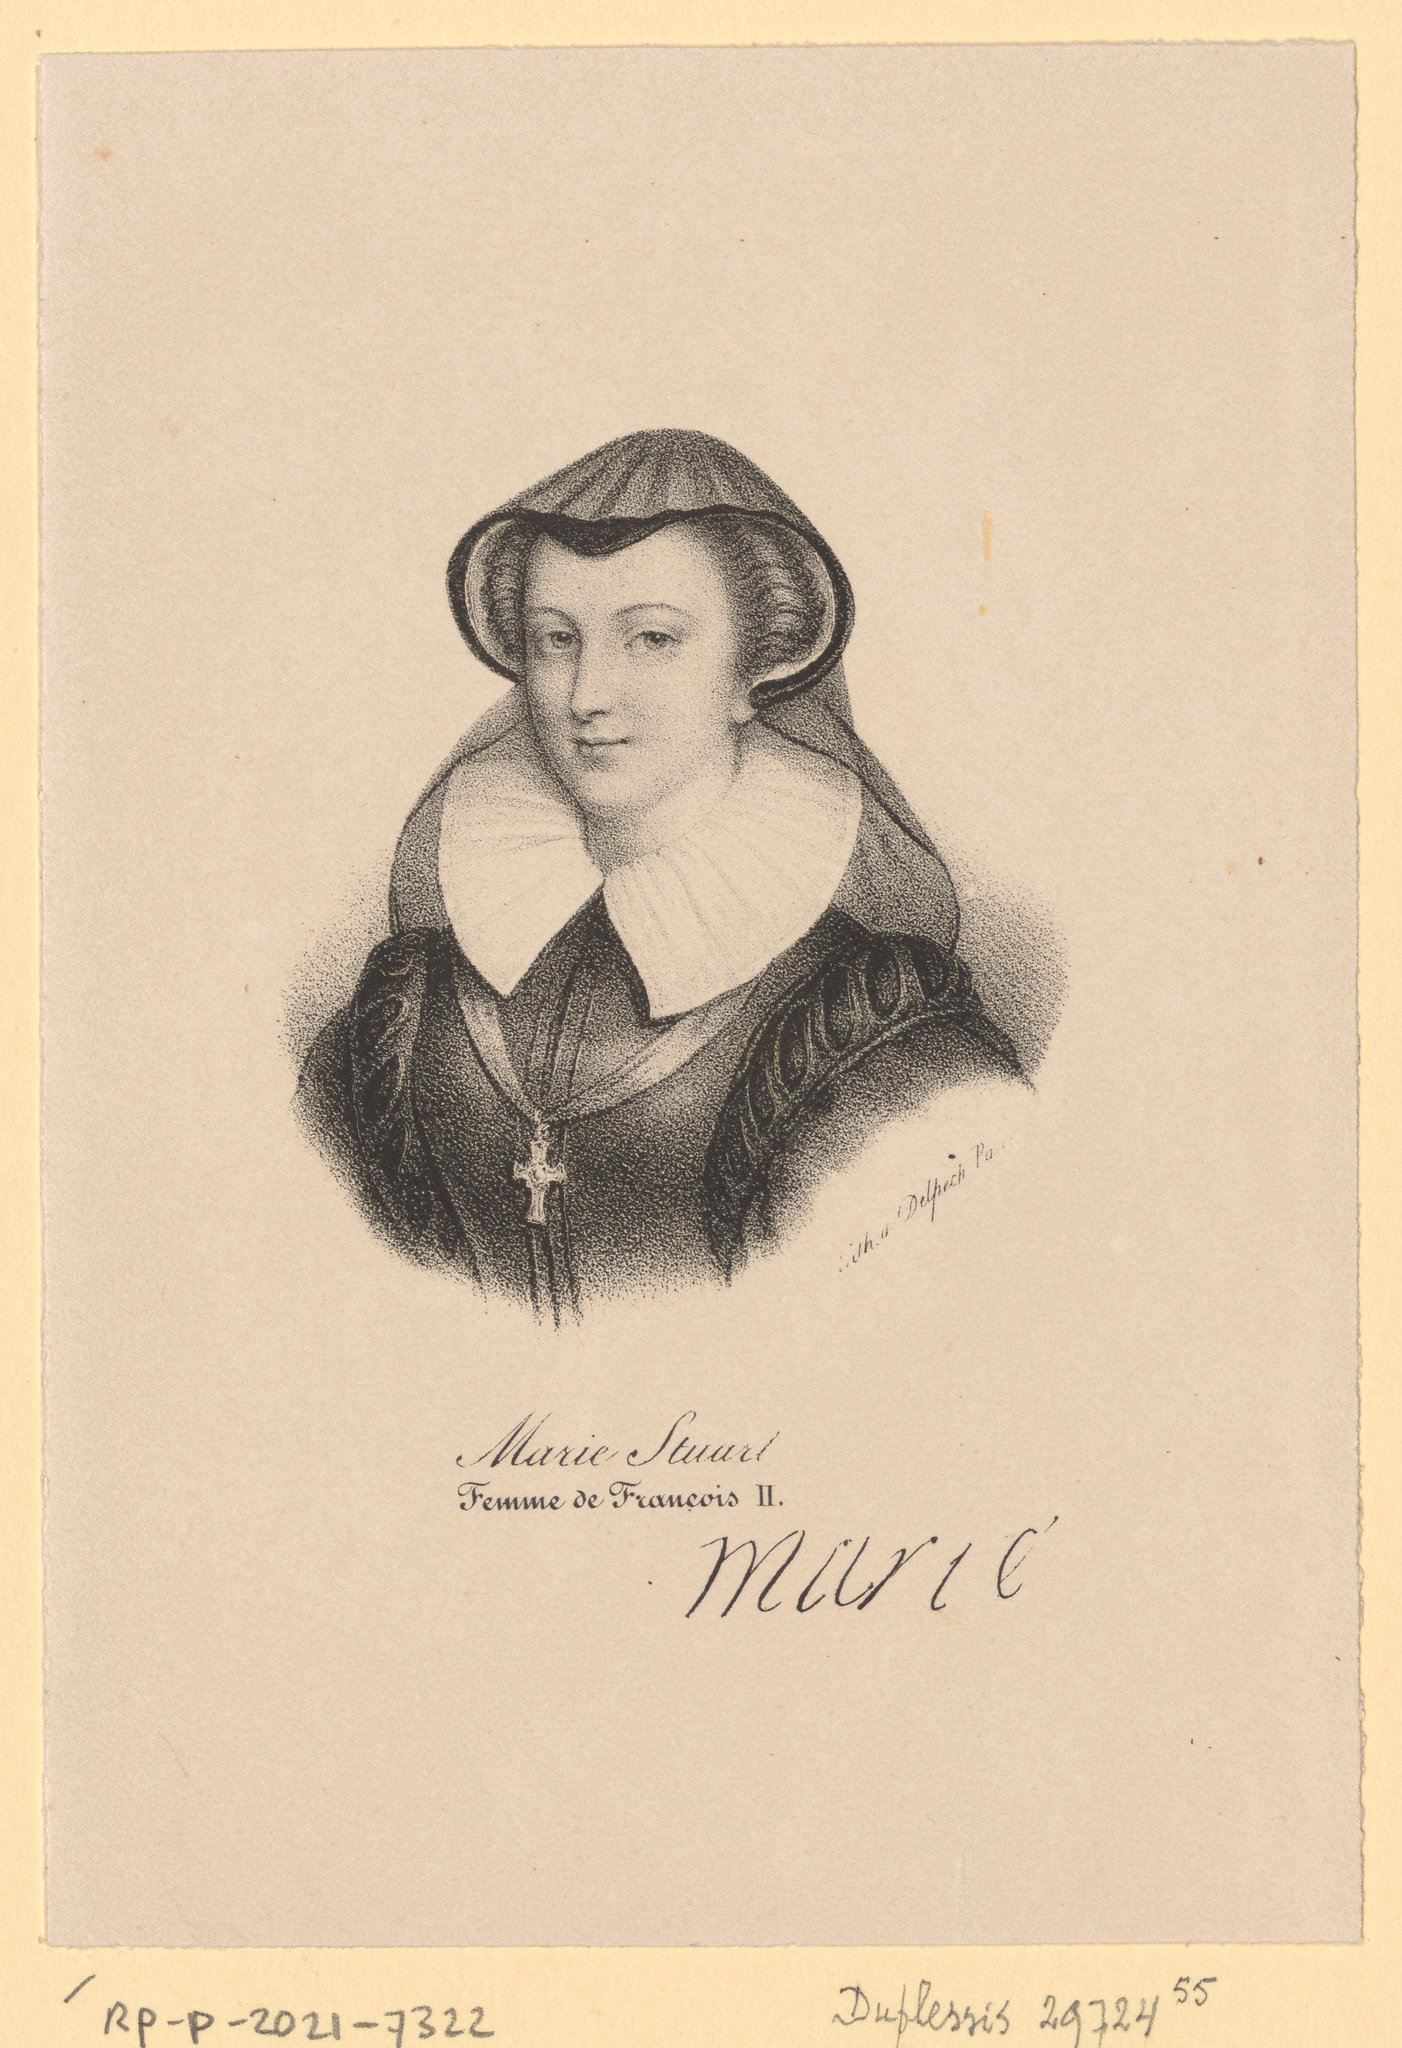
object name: print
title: Portret van Maria I van Schotland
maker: Anonymous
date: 1818-1842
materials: paper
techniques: lithograph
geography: france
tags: historical persons - bb - woman, queen